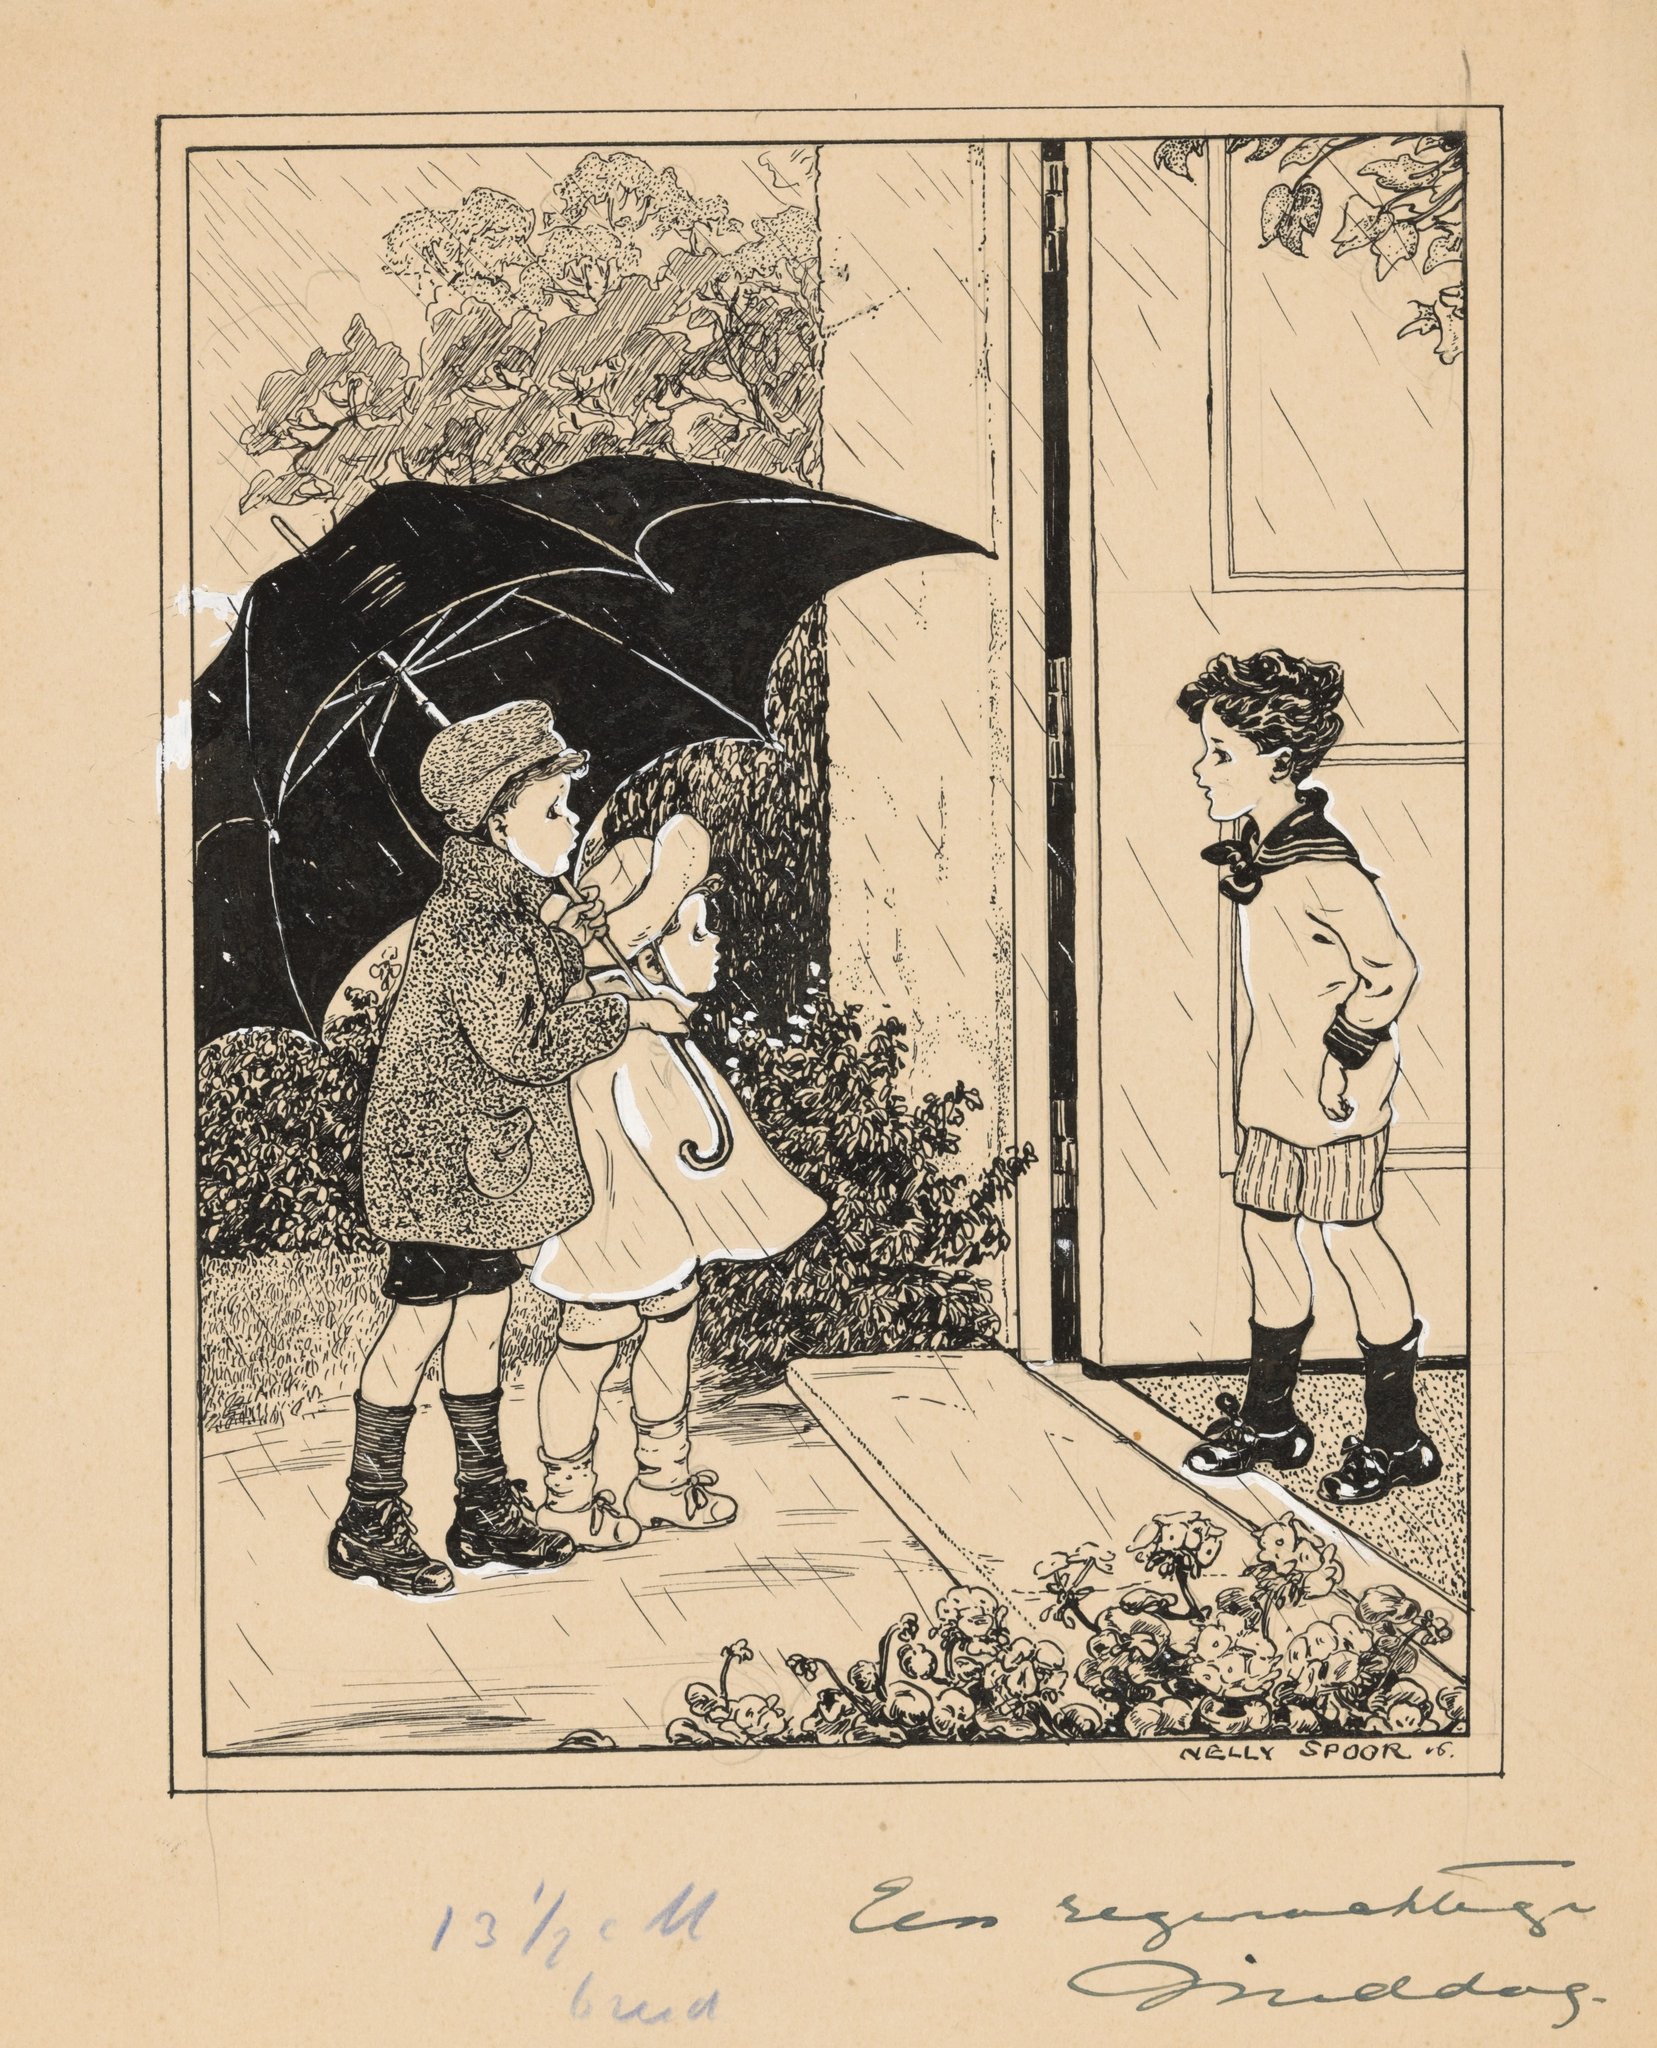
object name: boekillustratie ontwerp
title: Frits en Janneman voor Tommy's deur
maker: nelly spoor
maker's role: draughtsman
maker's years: 1885-1950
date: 1916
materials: paint, ink, paper, pencil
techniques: brush, pen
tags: open door, child, rain, umbrella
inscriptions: :, collector's mark: Lugt 2228, annotation: ‘Een regenachtige/ dinsdag.’, signature and date: ‘NELLY SPOOR 16.’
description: Frits en Janneman staan in de regen onder een paraplu voor de deur van Tommy. Tommy staat in de deuropening in een matrozenpak.